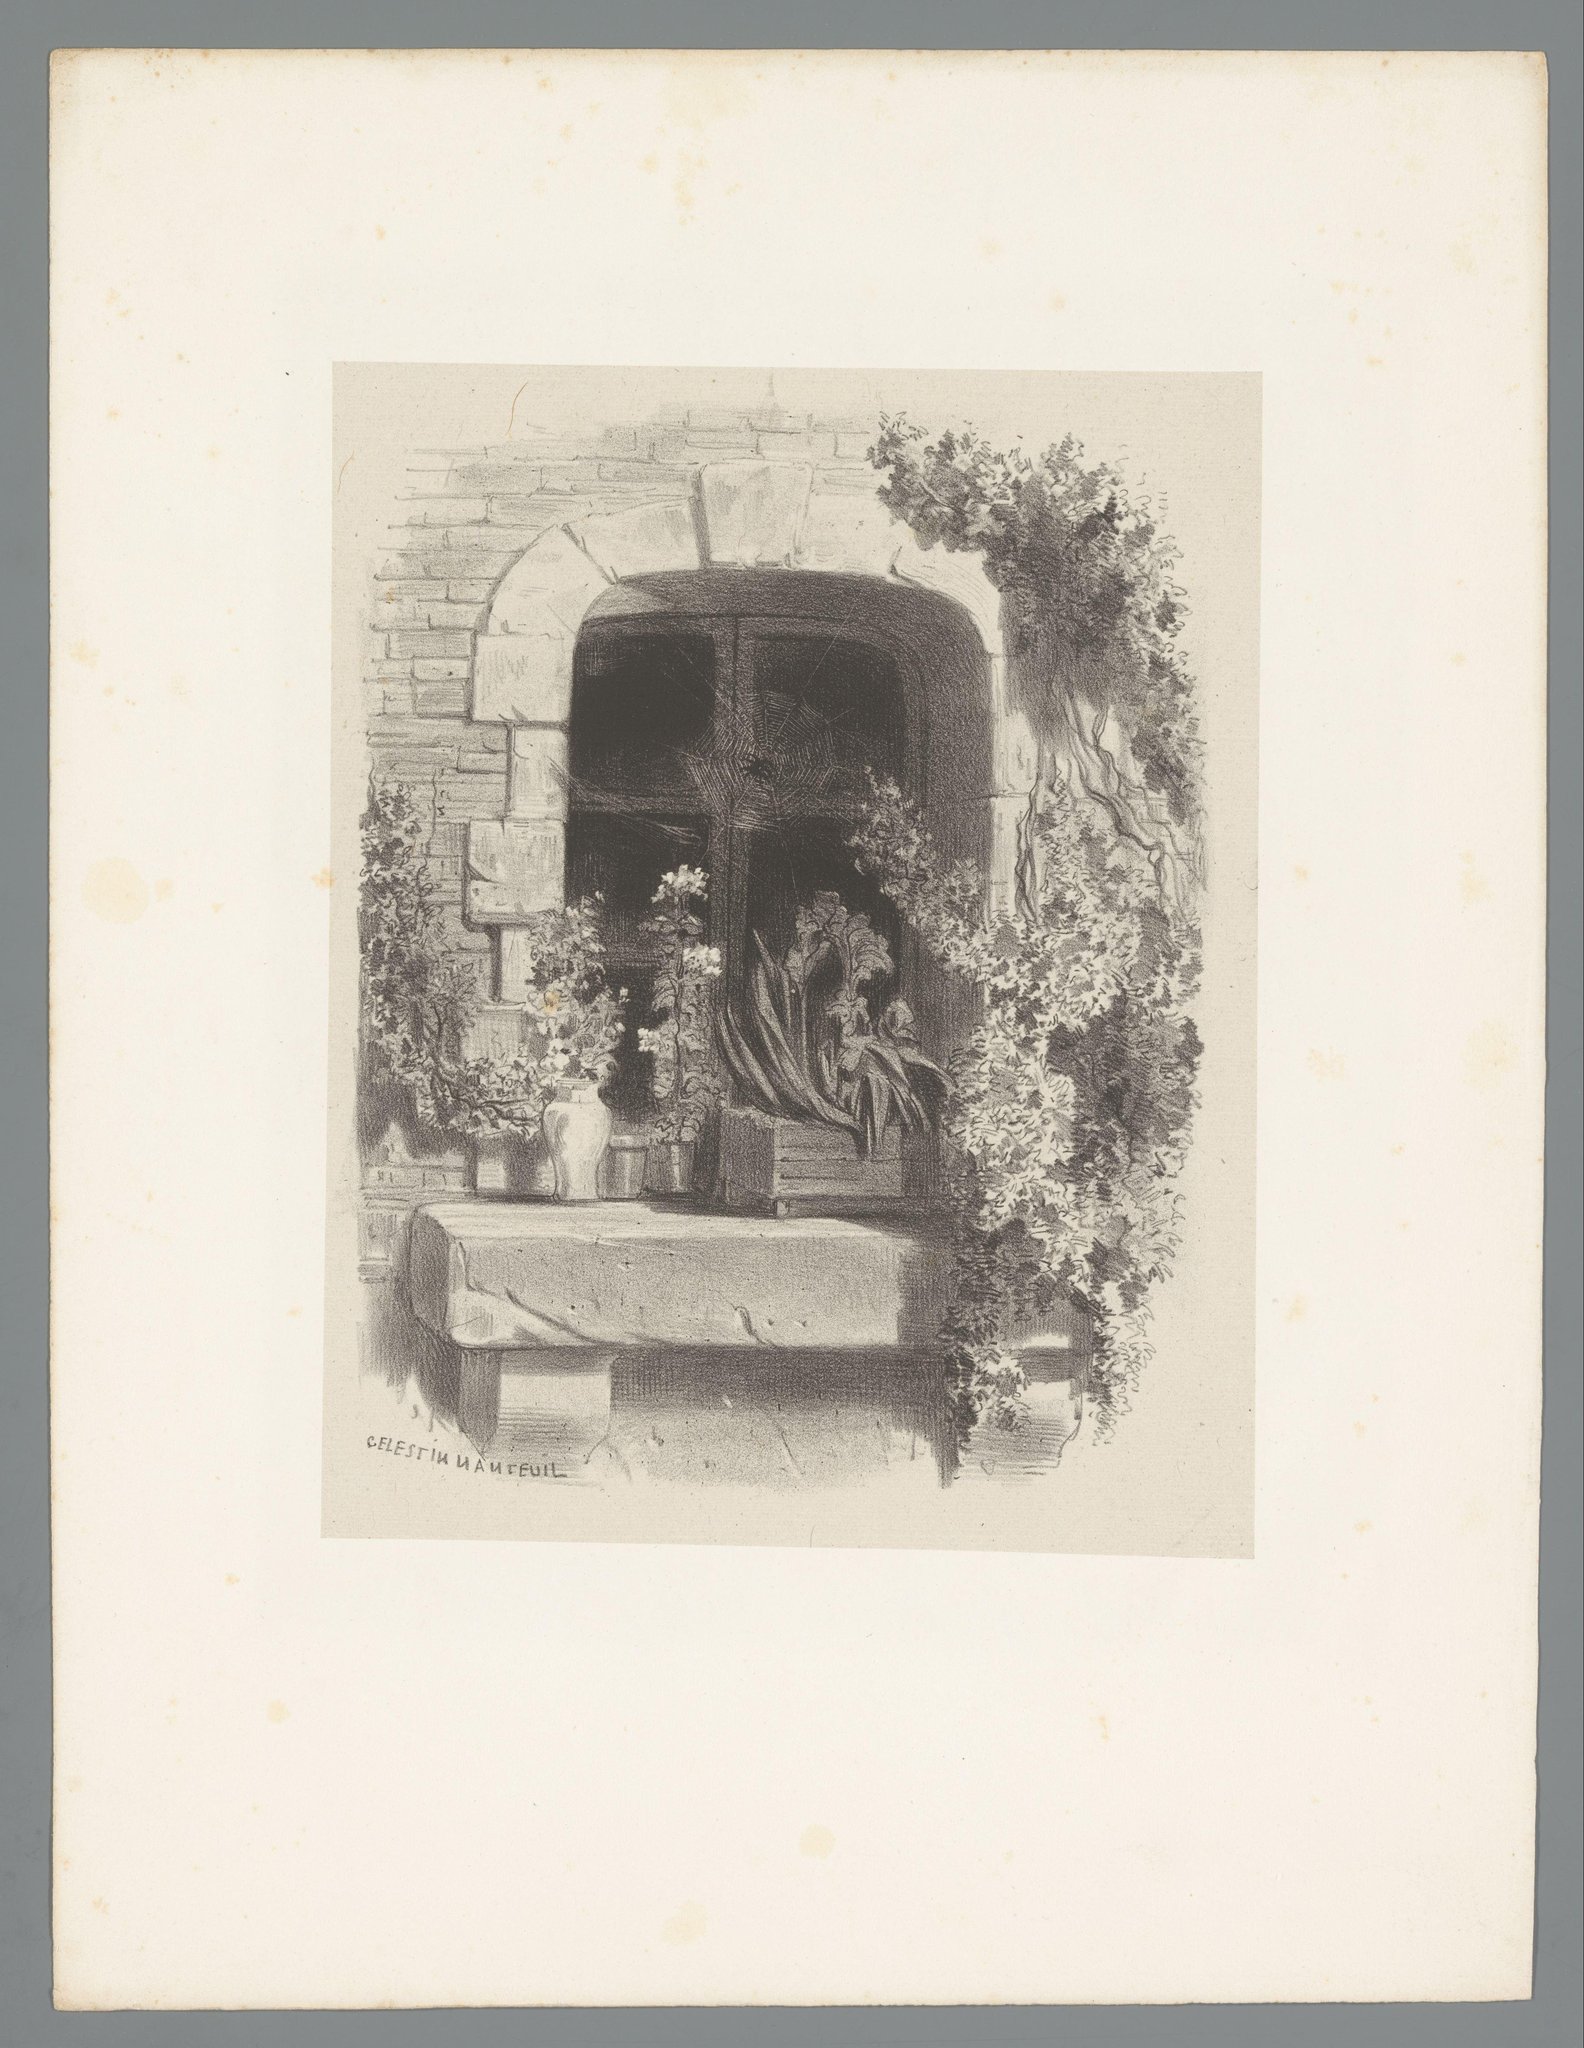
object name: print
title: Raam met spinnenweb en planten, gezien vanaf buiten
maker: célestin françois nanteuil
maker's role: print maker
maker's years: 1813-1873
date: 1823-1873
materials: paper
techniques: lithograph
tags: plants; vegetation, spiders, closed window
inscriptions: collector's mark: Lugt 964